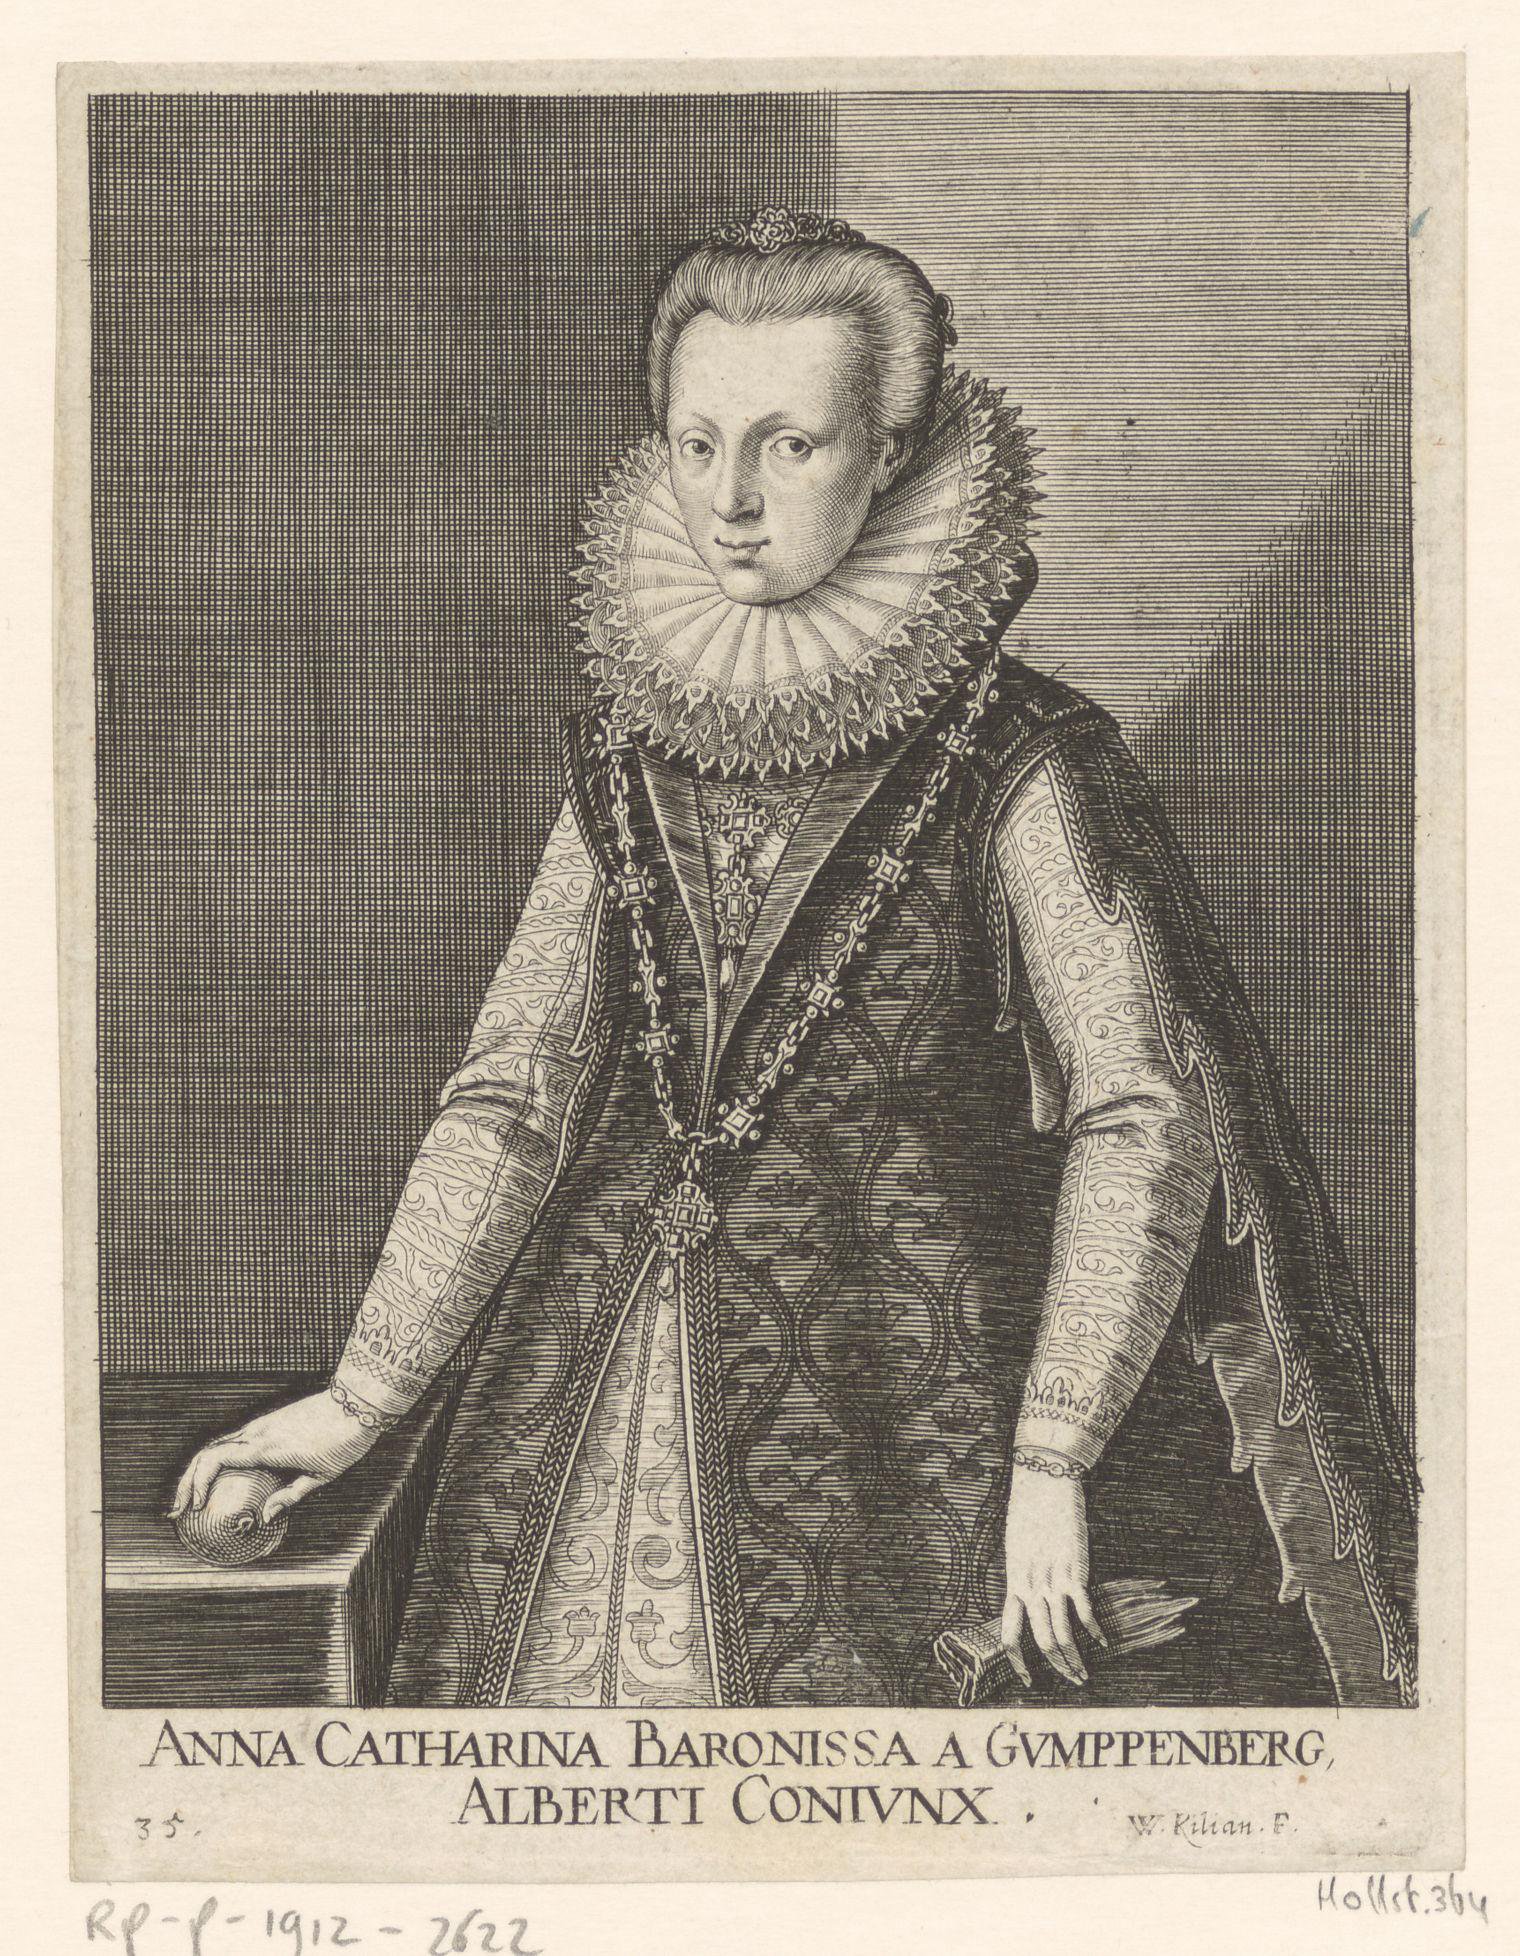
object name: print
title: Portret van Anna Catharina von Gumppenberg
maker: wolfgang kilian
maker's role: print maker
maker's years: 1581-1662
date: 1600-1662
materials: paper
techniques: engraving, etching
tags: historical persons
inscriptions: collector's mark: Lugt 2228